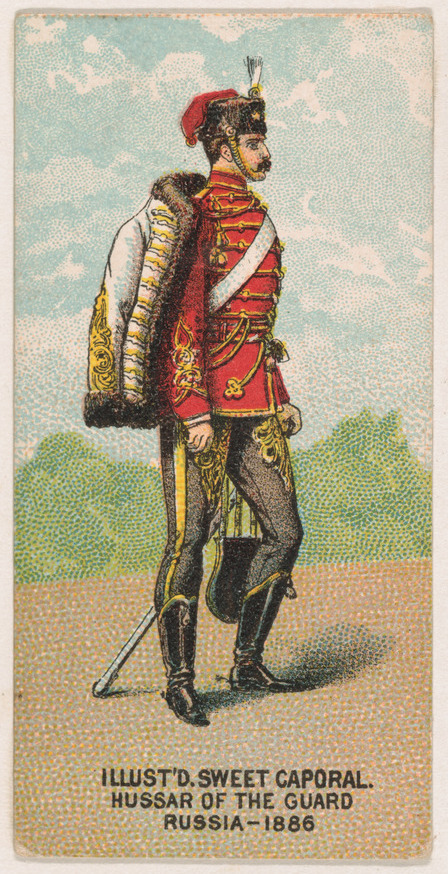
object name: print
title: Hussar of the Guard, Russia, 1886, from the Military Series (N224) issued by Kinney Tobacco Company to promote Sweet Caporal Cigarettes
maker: kinney brothers tobacco company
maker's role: publisher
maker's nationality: american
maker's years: 1869-2011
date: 1888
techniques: color lithograph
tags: military,men,profiles